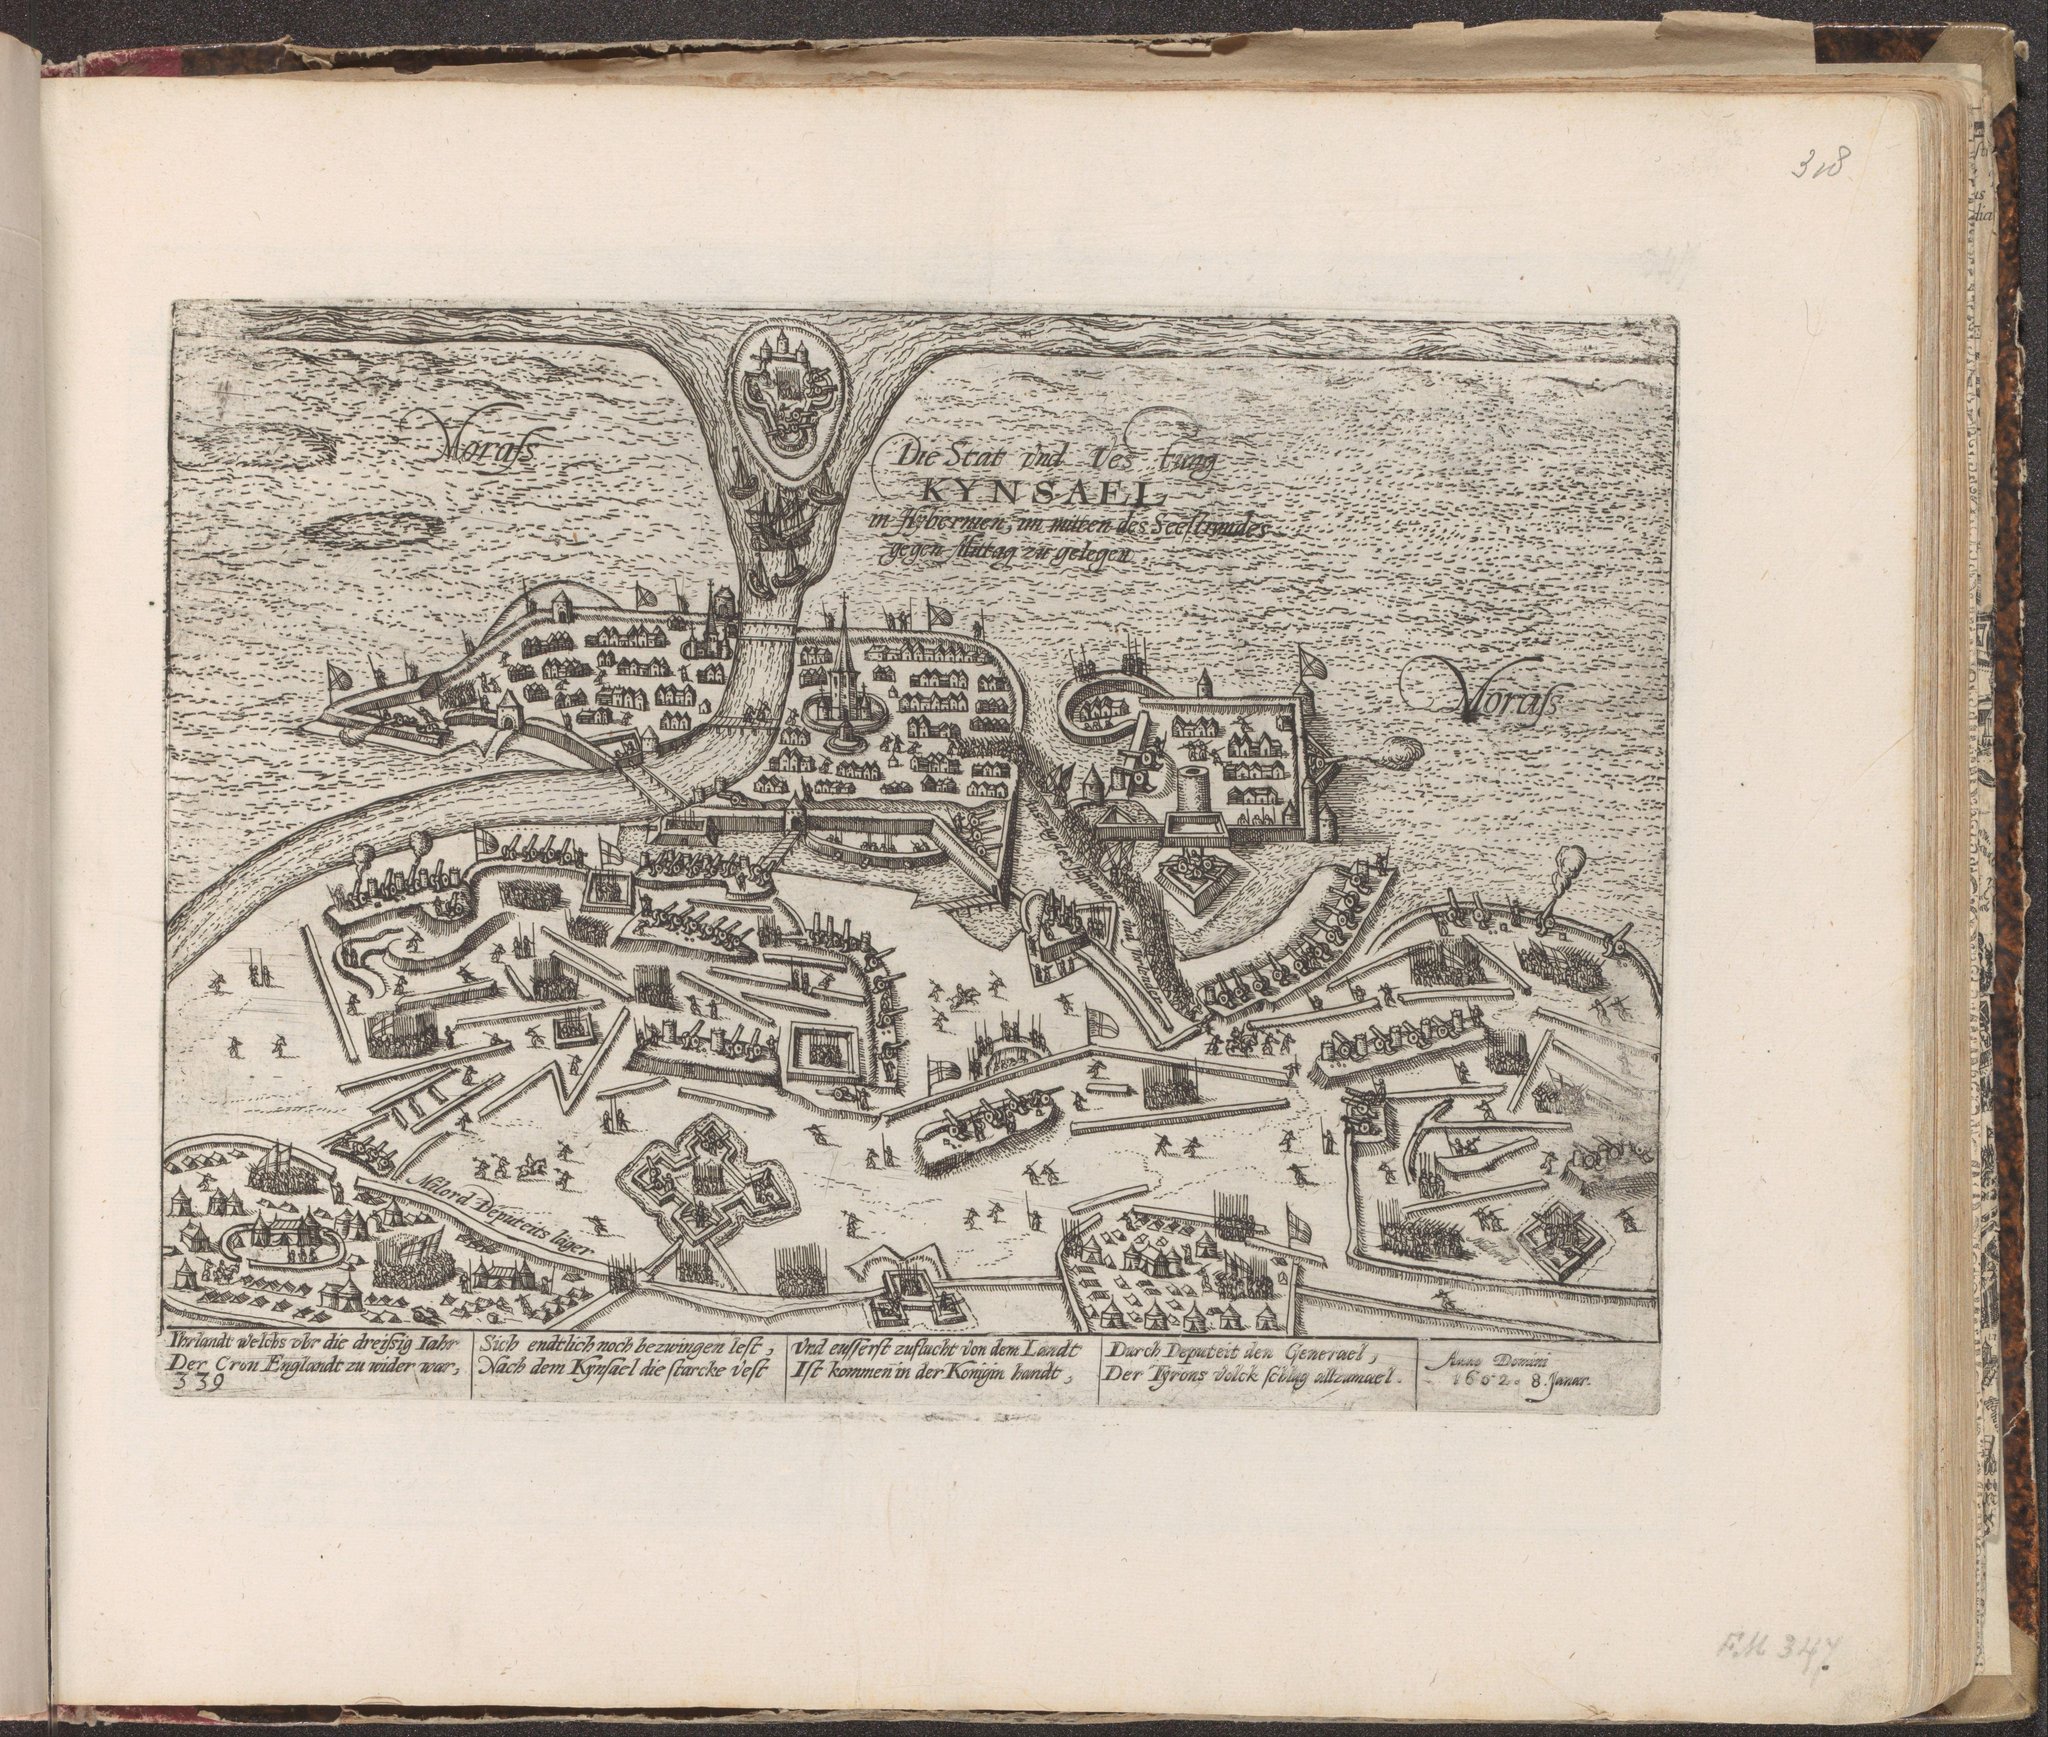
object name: print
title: Kinsale in Ierland gaat aan Elizabeth over, 1602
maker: frans hogenberg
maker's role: print maker, publisher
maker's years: 1538-1590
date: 1602-1604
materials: paper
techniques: etching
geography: cologne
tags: siege, position war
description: Kinsale in Ierland gaat aan Elizabeth I over, 8 januari 1602. De stad omsingeld door belegeraars, na overgave vertrekken de Spaanse en Ierse soldaten uit de stad. Met onderschrift van 8 regels in het Duits. Linksonder genummerd: 339. De prent maakt deel uit van een album.